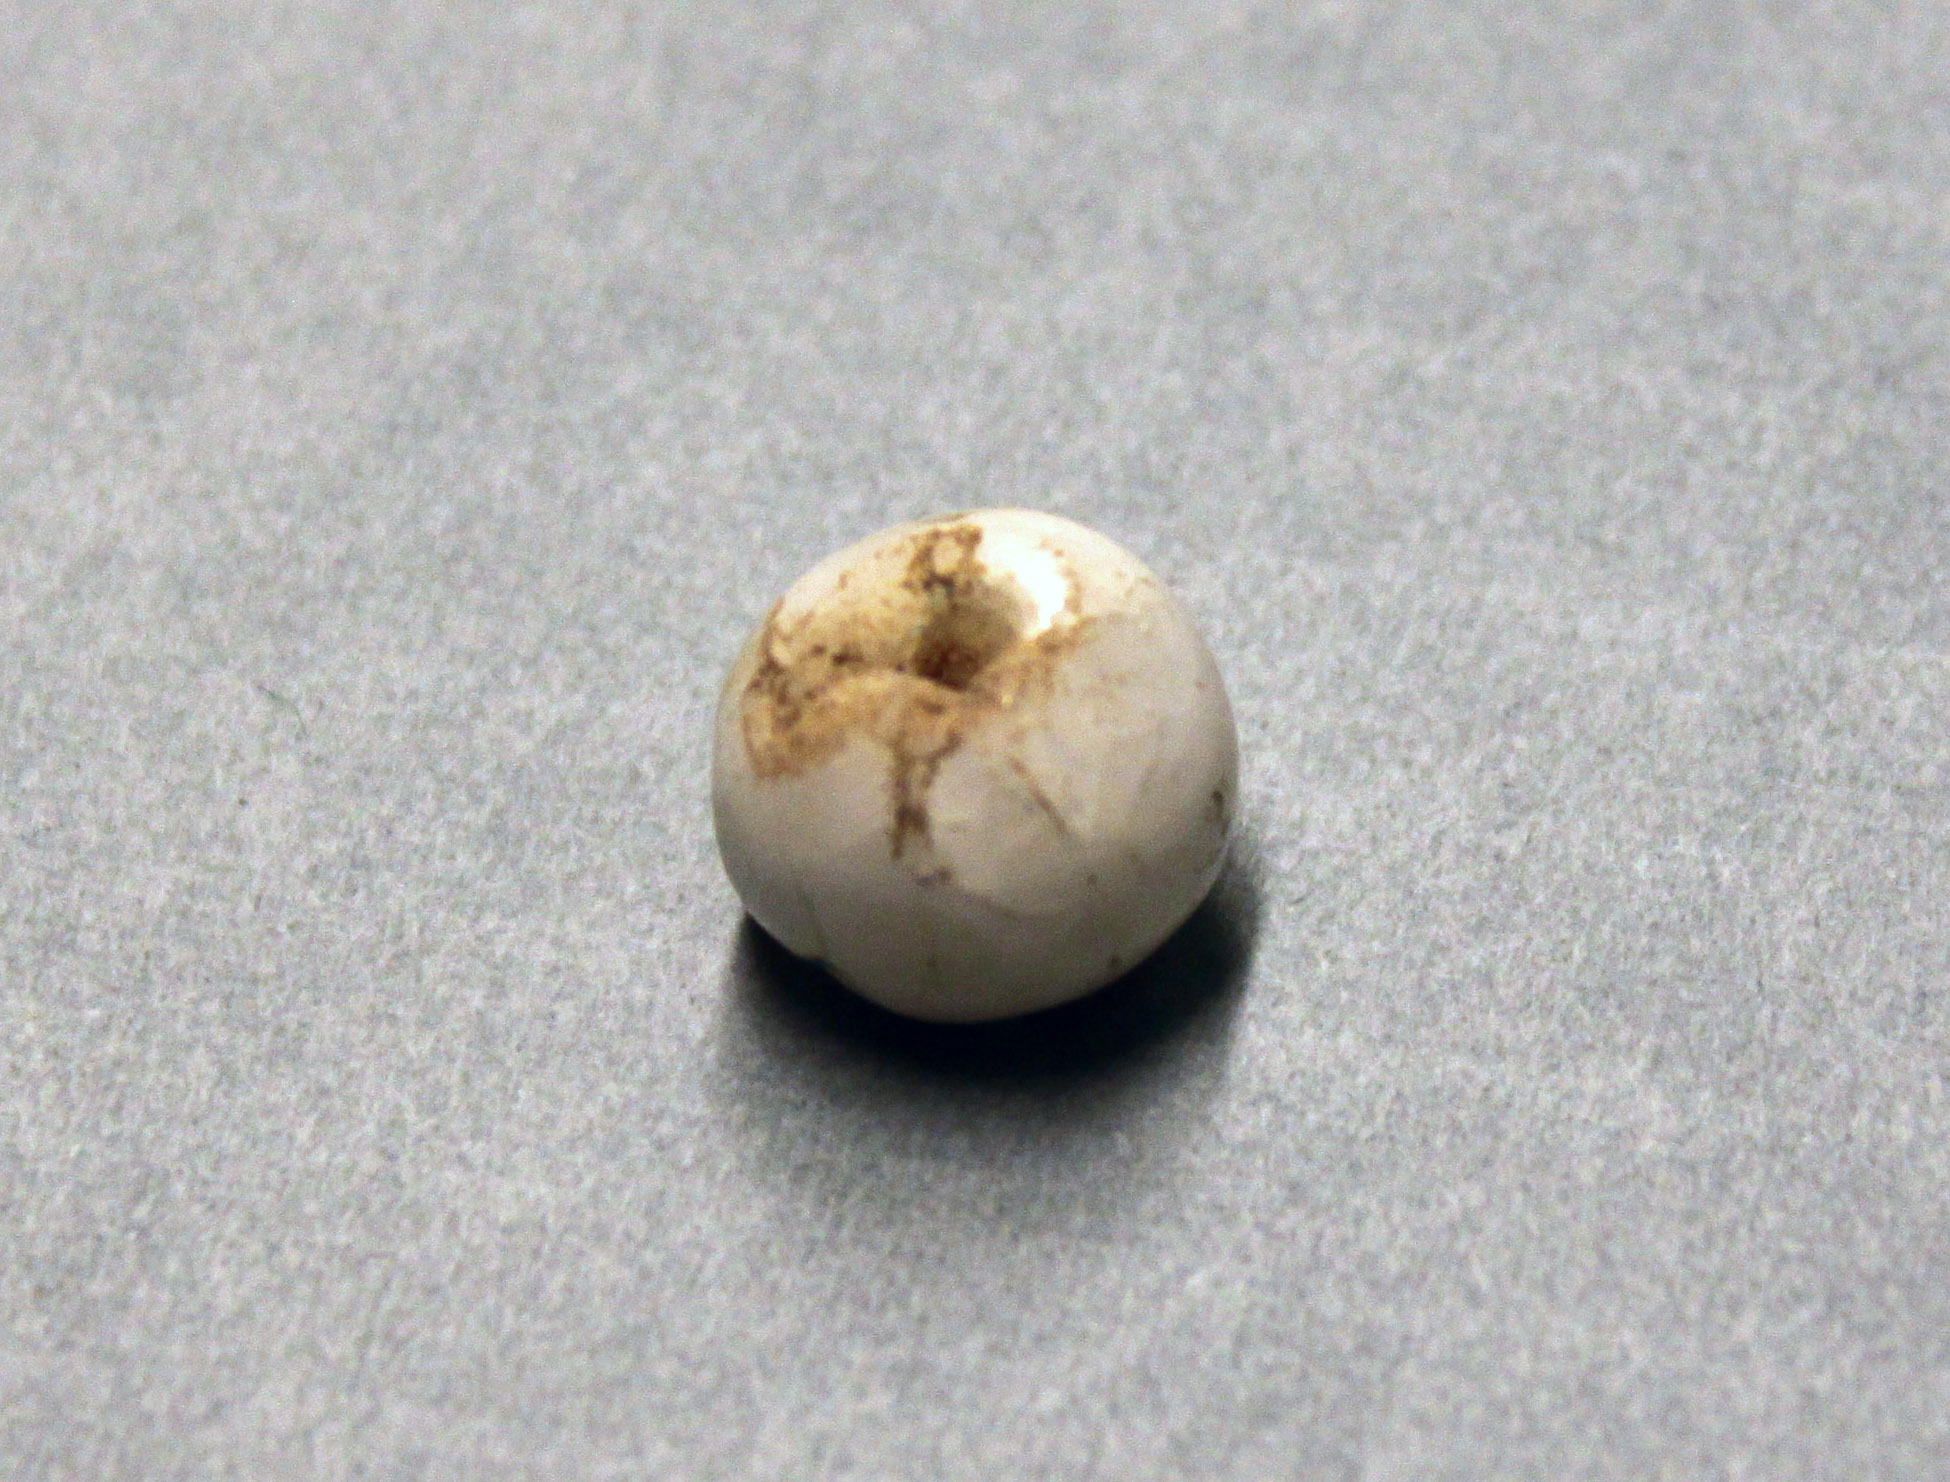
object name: bead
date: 701-1200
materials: stone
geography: iran